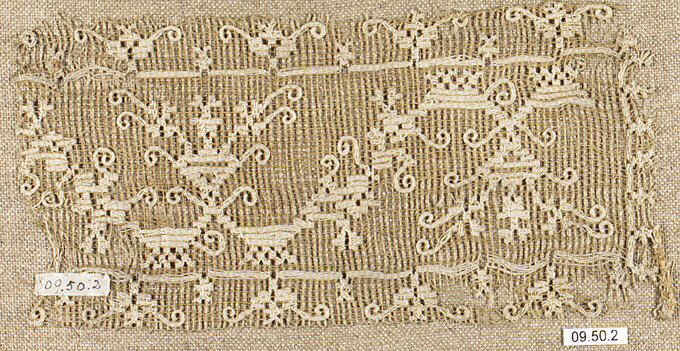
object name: fragment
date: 1501-1600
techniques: embroidery